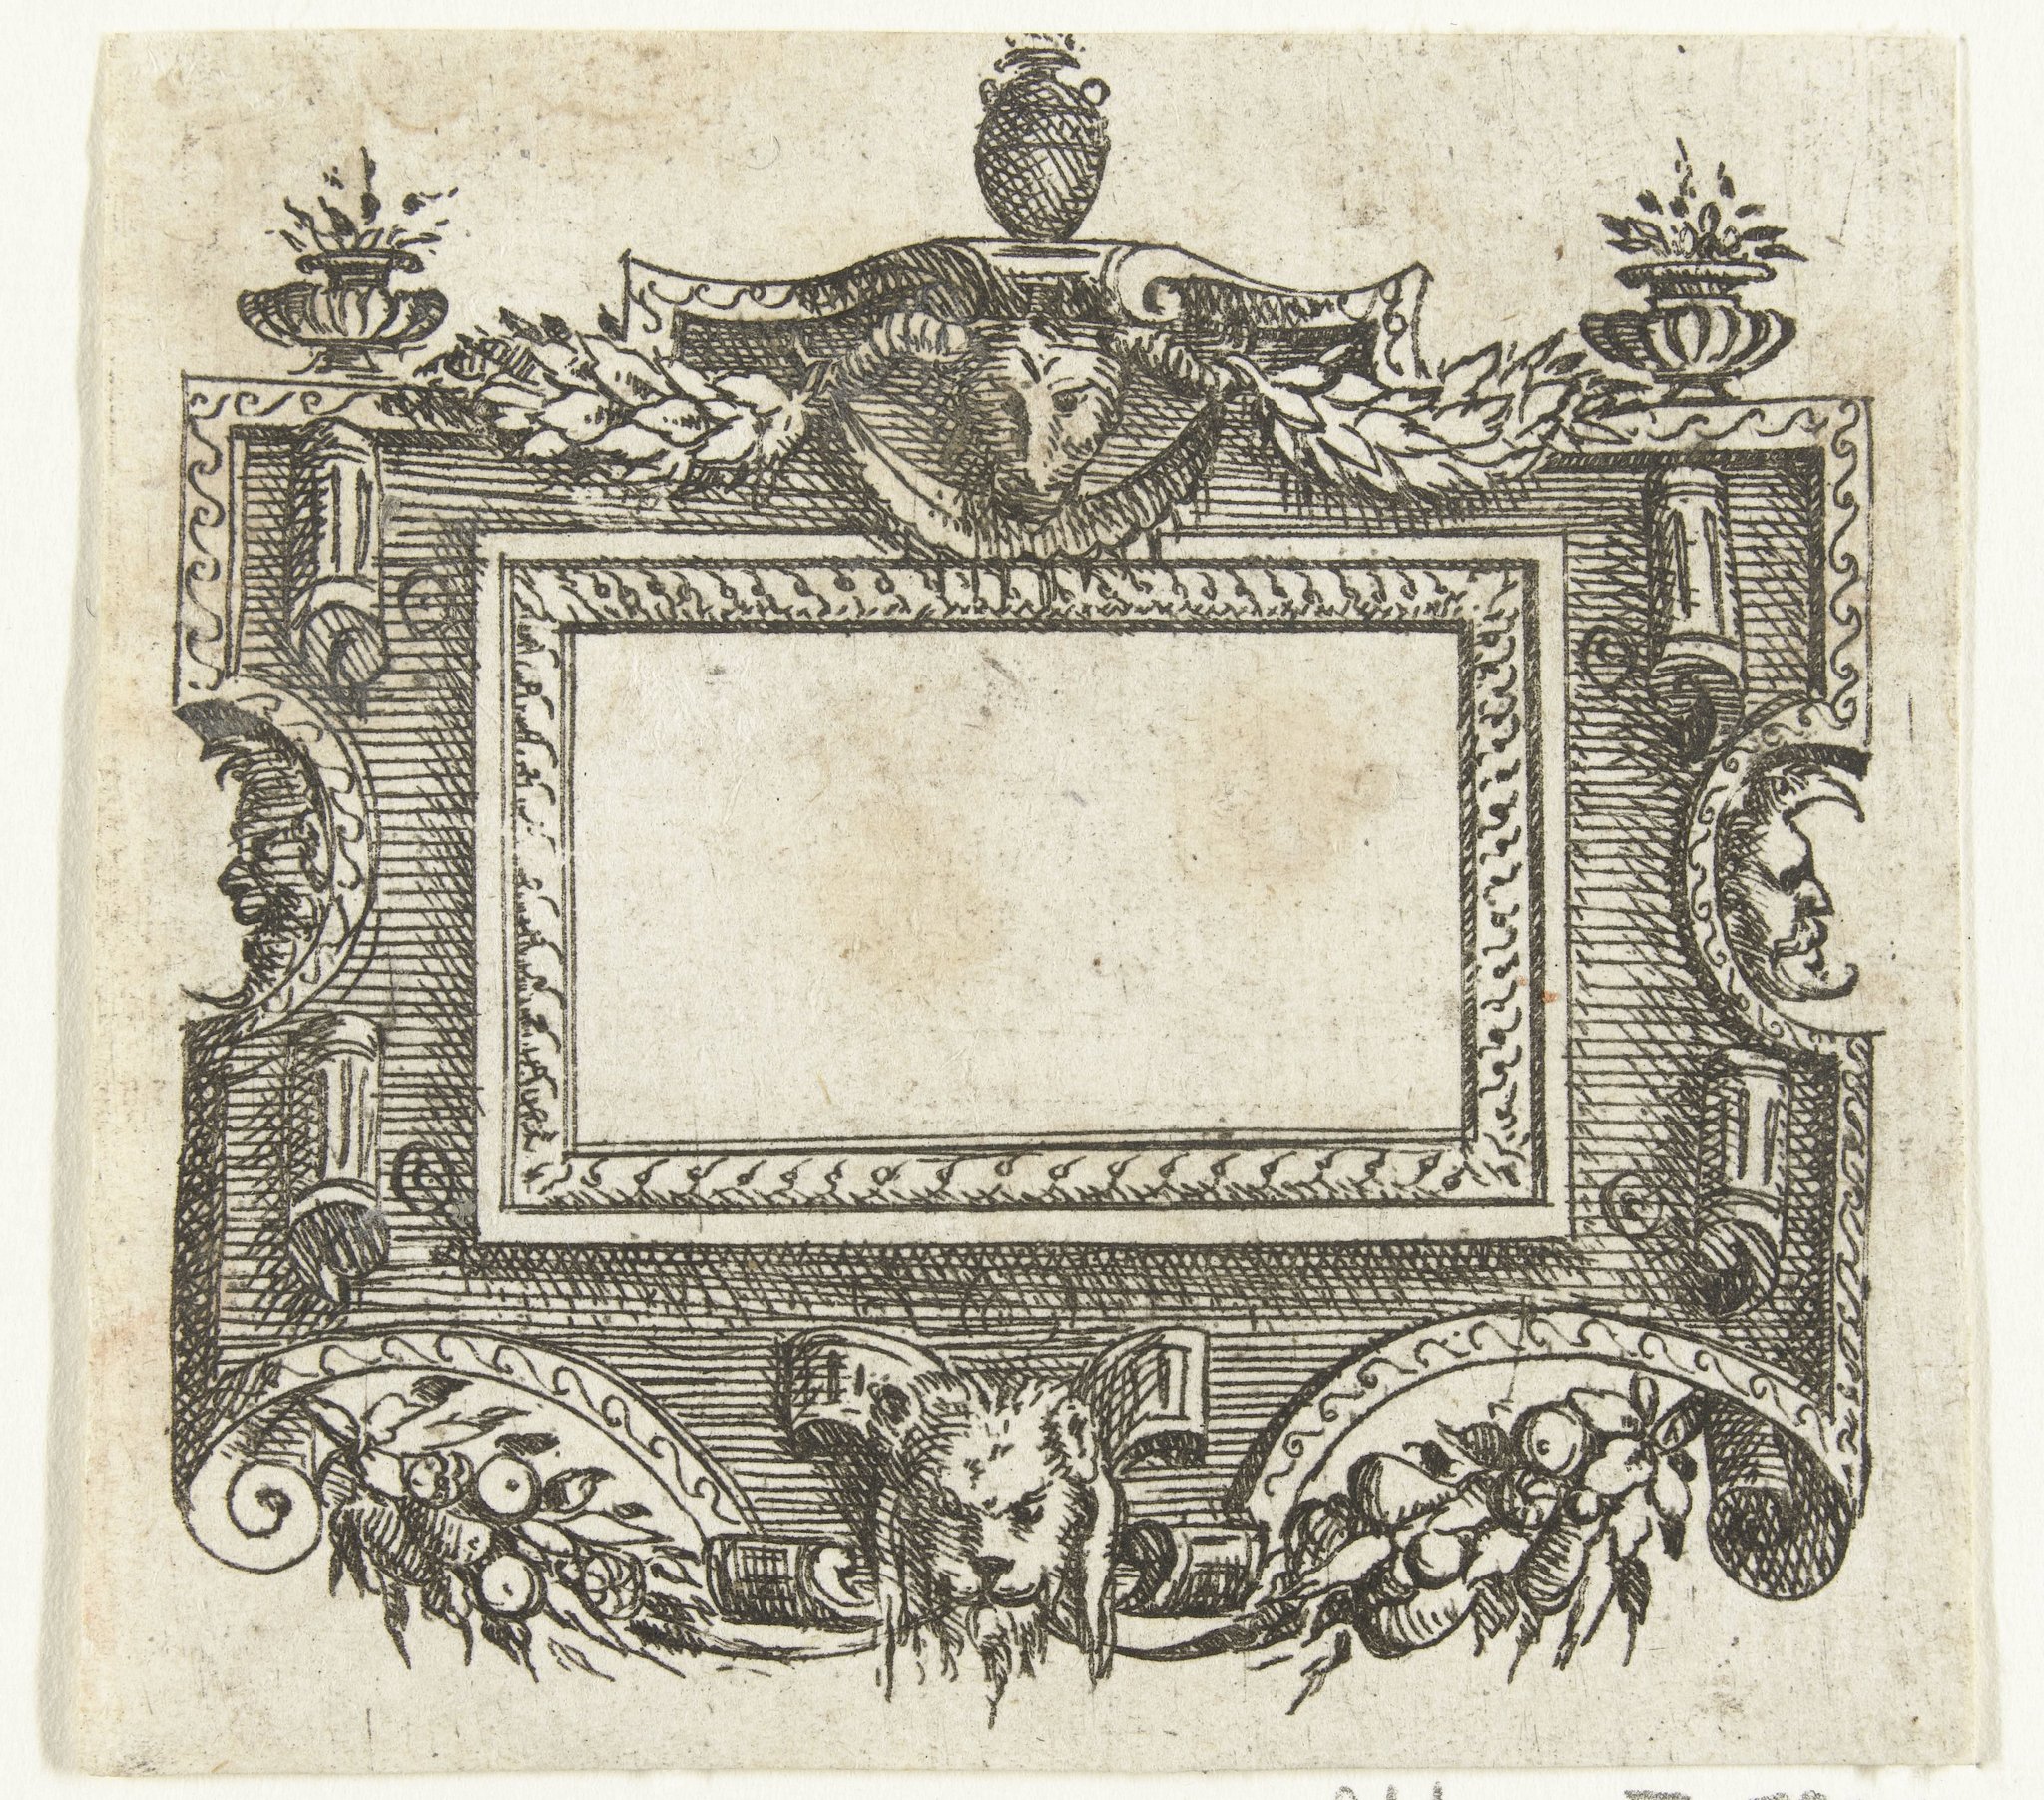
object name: print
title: Cartouches in een omlijsting van rolwerk met grotesken, mascarons en guirlandes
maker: Anonymous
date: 1500-1600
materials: paper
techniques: etching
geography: france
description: Op de bovenrand van de cartouche staan drie vazen. Uit serie van 17 bladen.